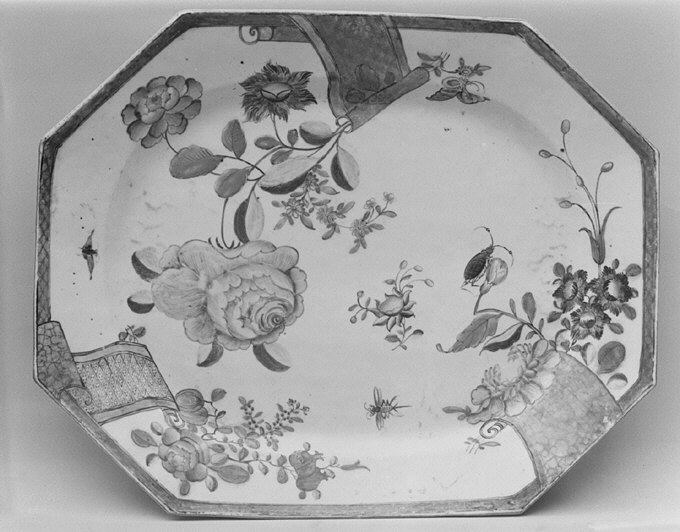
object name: platter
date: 1765-1775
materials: hard paste porcelain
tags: flowers